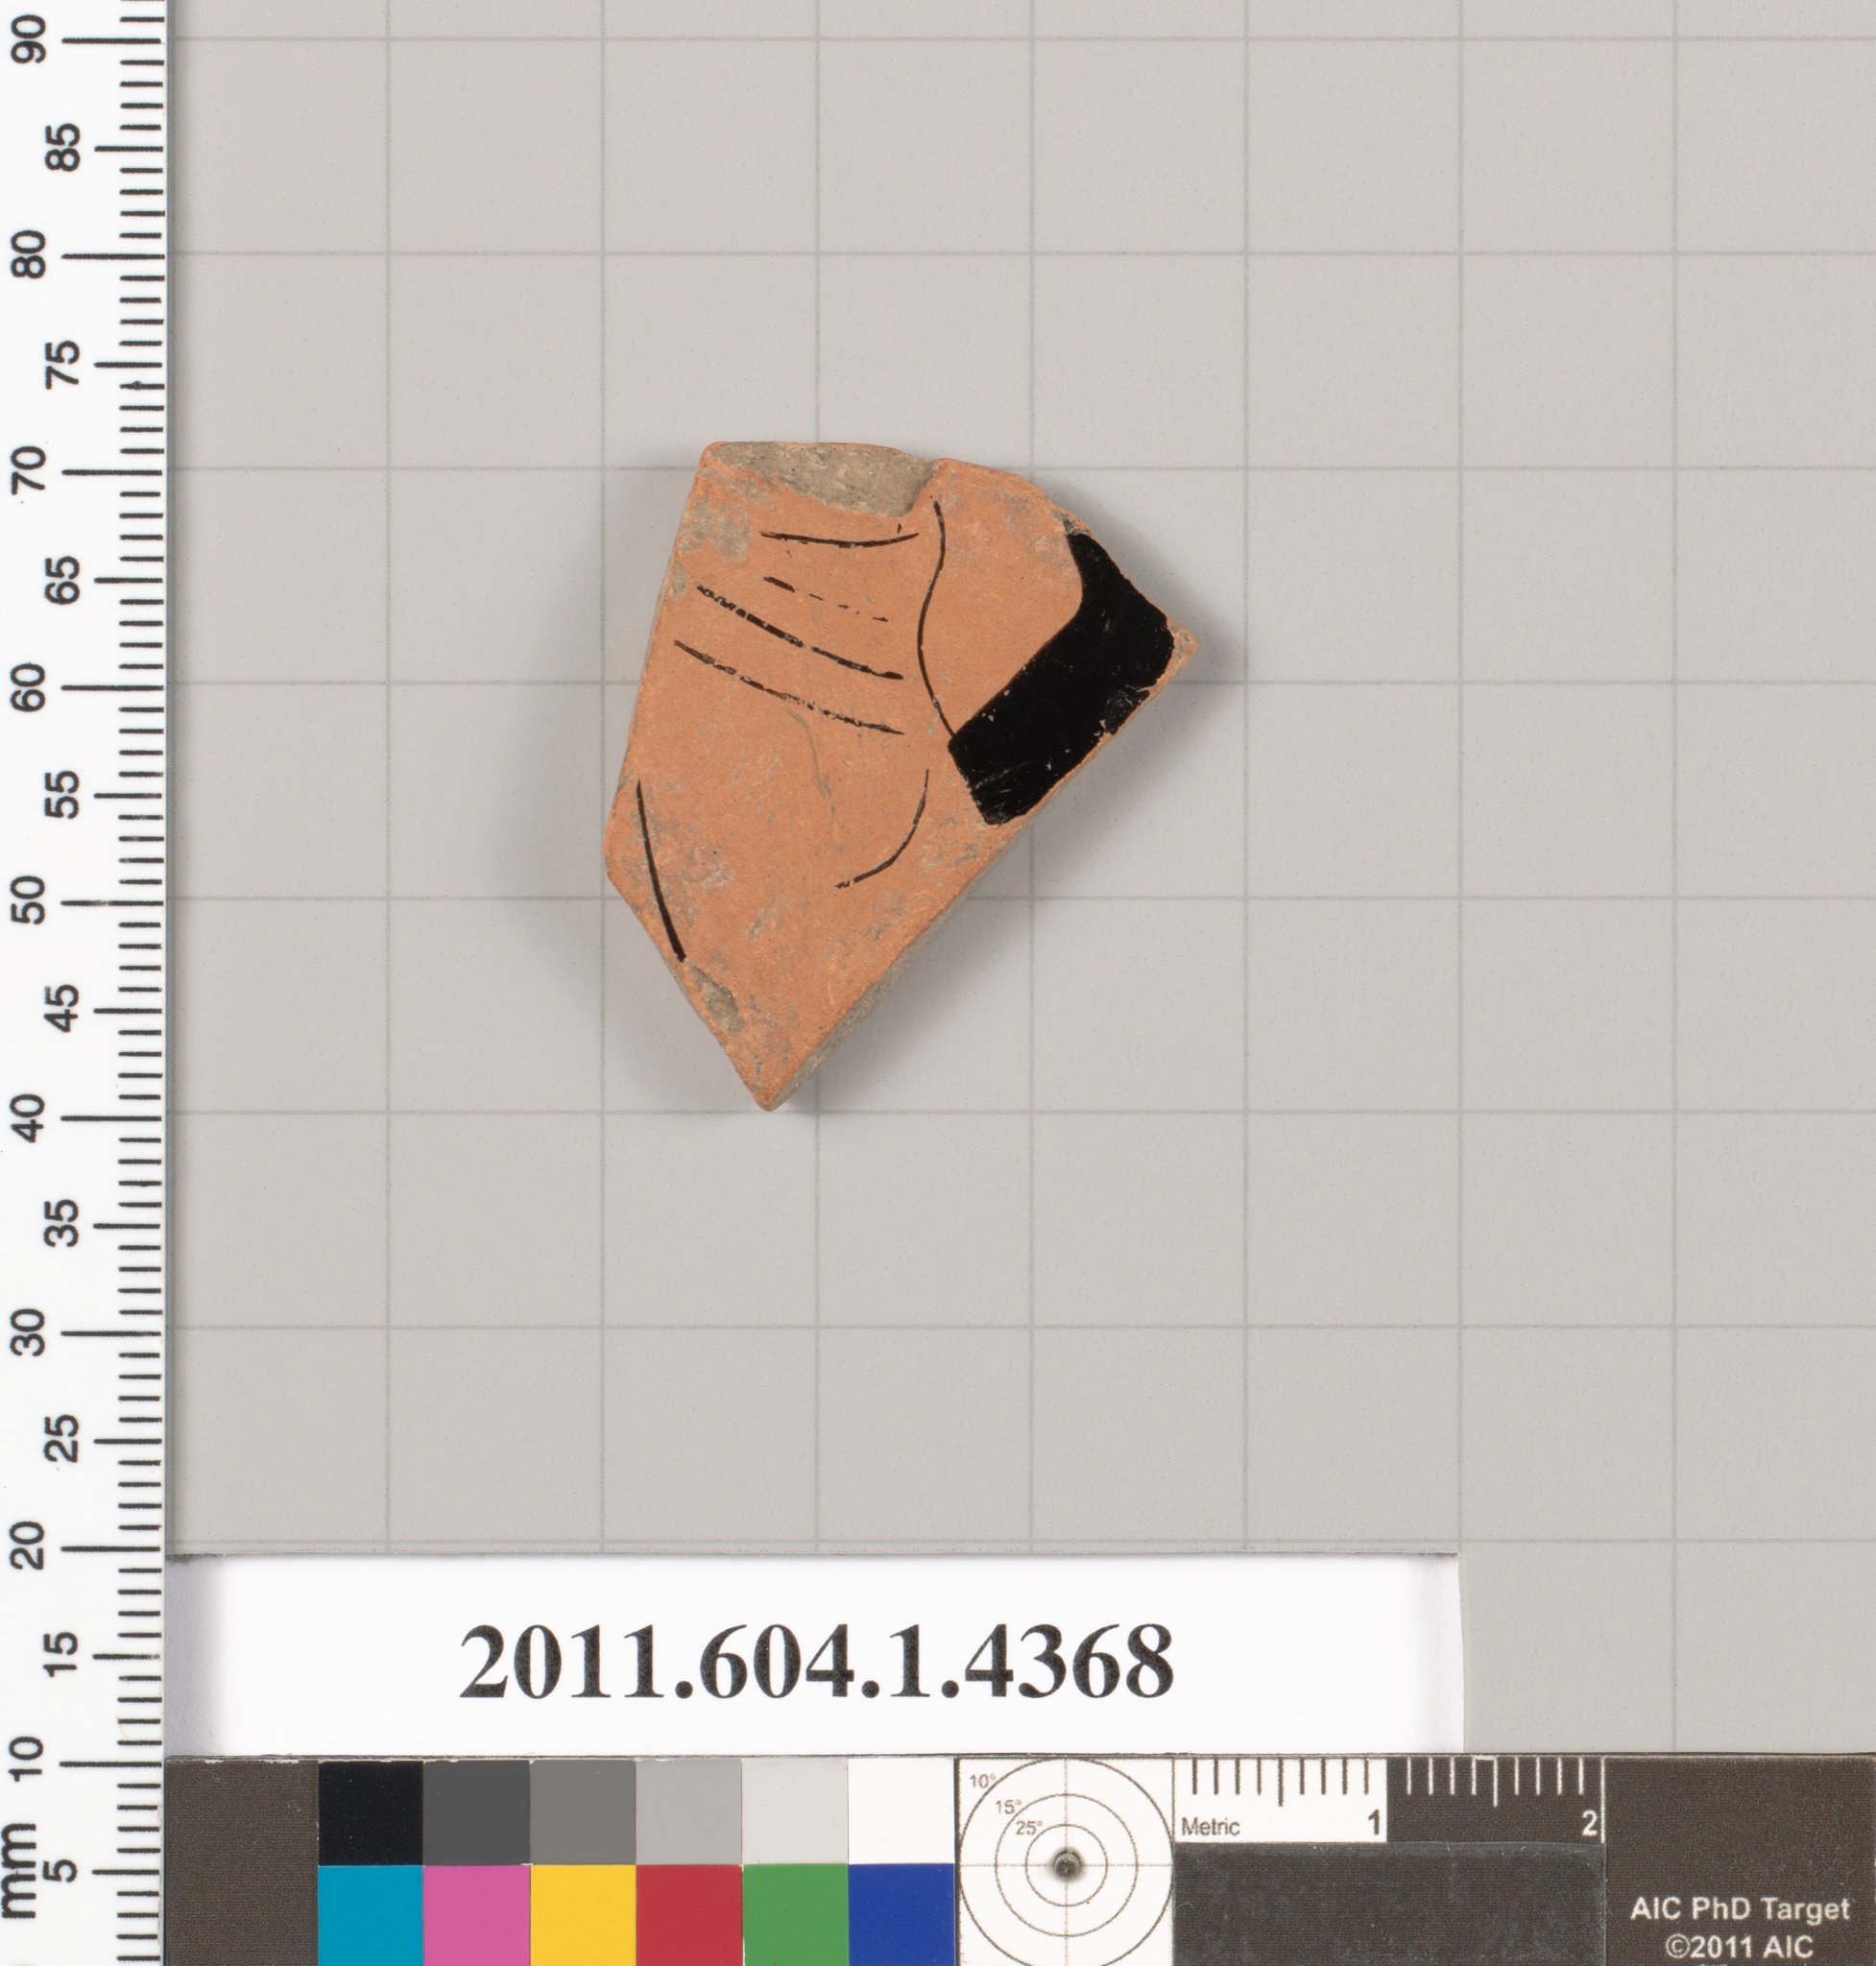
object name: kylix fragment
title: Terracotta fragment of a kylix (drinking cup)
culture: greek, attic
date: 475-451 BCE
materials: terracotta